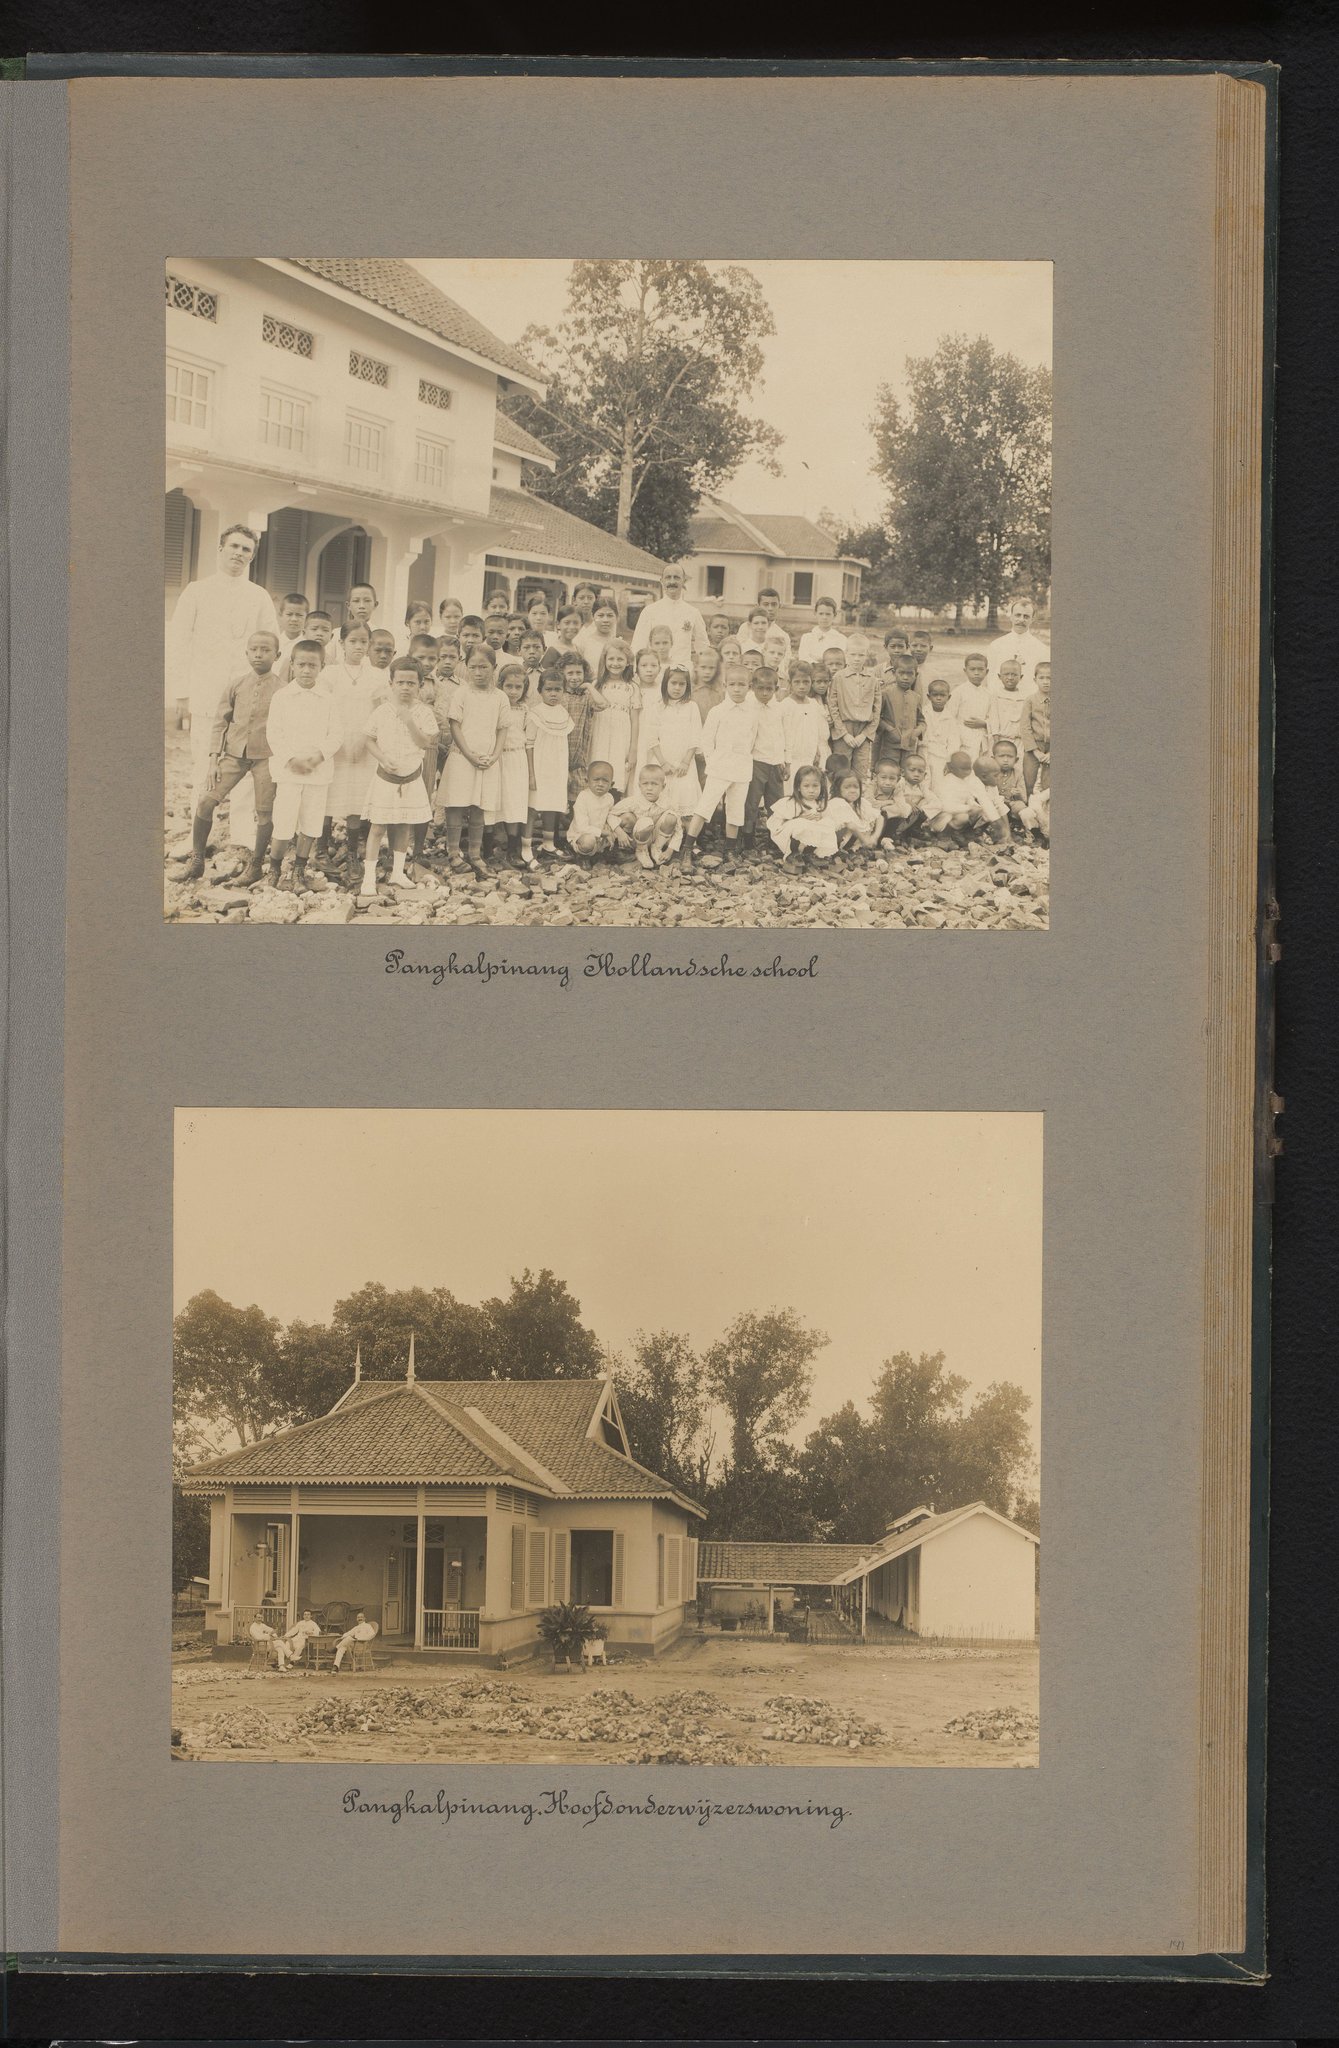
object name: album leaf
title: Staf en leerlingen en onderwijzerswoning te Pangkalpinang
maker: Anonymous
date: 1914-1919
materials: cardboard, photographic support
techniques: gelatin silver print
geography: bangka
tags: robert julius boers, colonial system, mining, elementary school; class, form (+ teacher, professor), elementary school; class, form (+ pupil), villa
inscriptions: inscription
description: Albumblad met 2 foto's van het staf en de leerlingen van de Hollandsche School en van de woning van de hoofdonderwijzer van de mijnbouwonderneming te Pangkalpinang. Onderdeel van het fotoalbum aangeboden aan Robert Julius Boers bij zijn vertrek naar Nederland in 1919 door het personeel van de Banka-tinwinning.